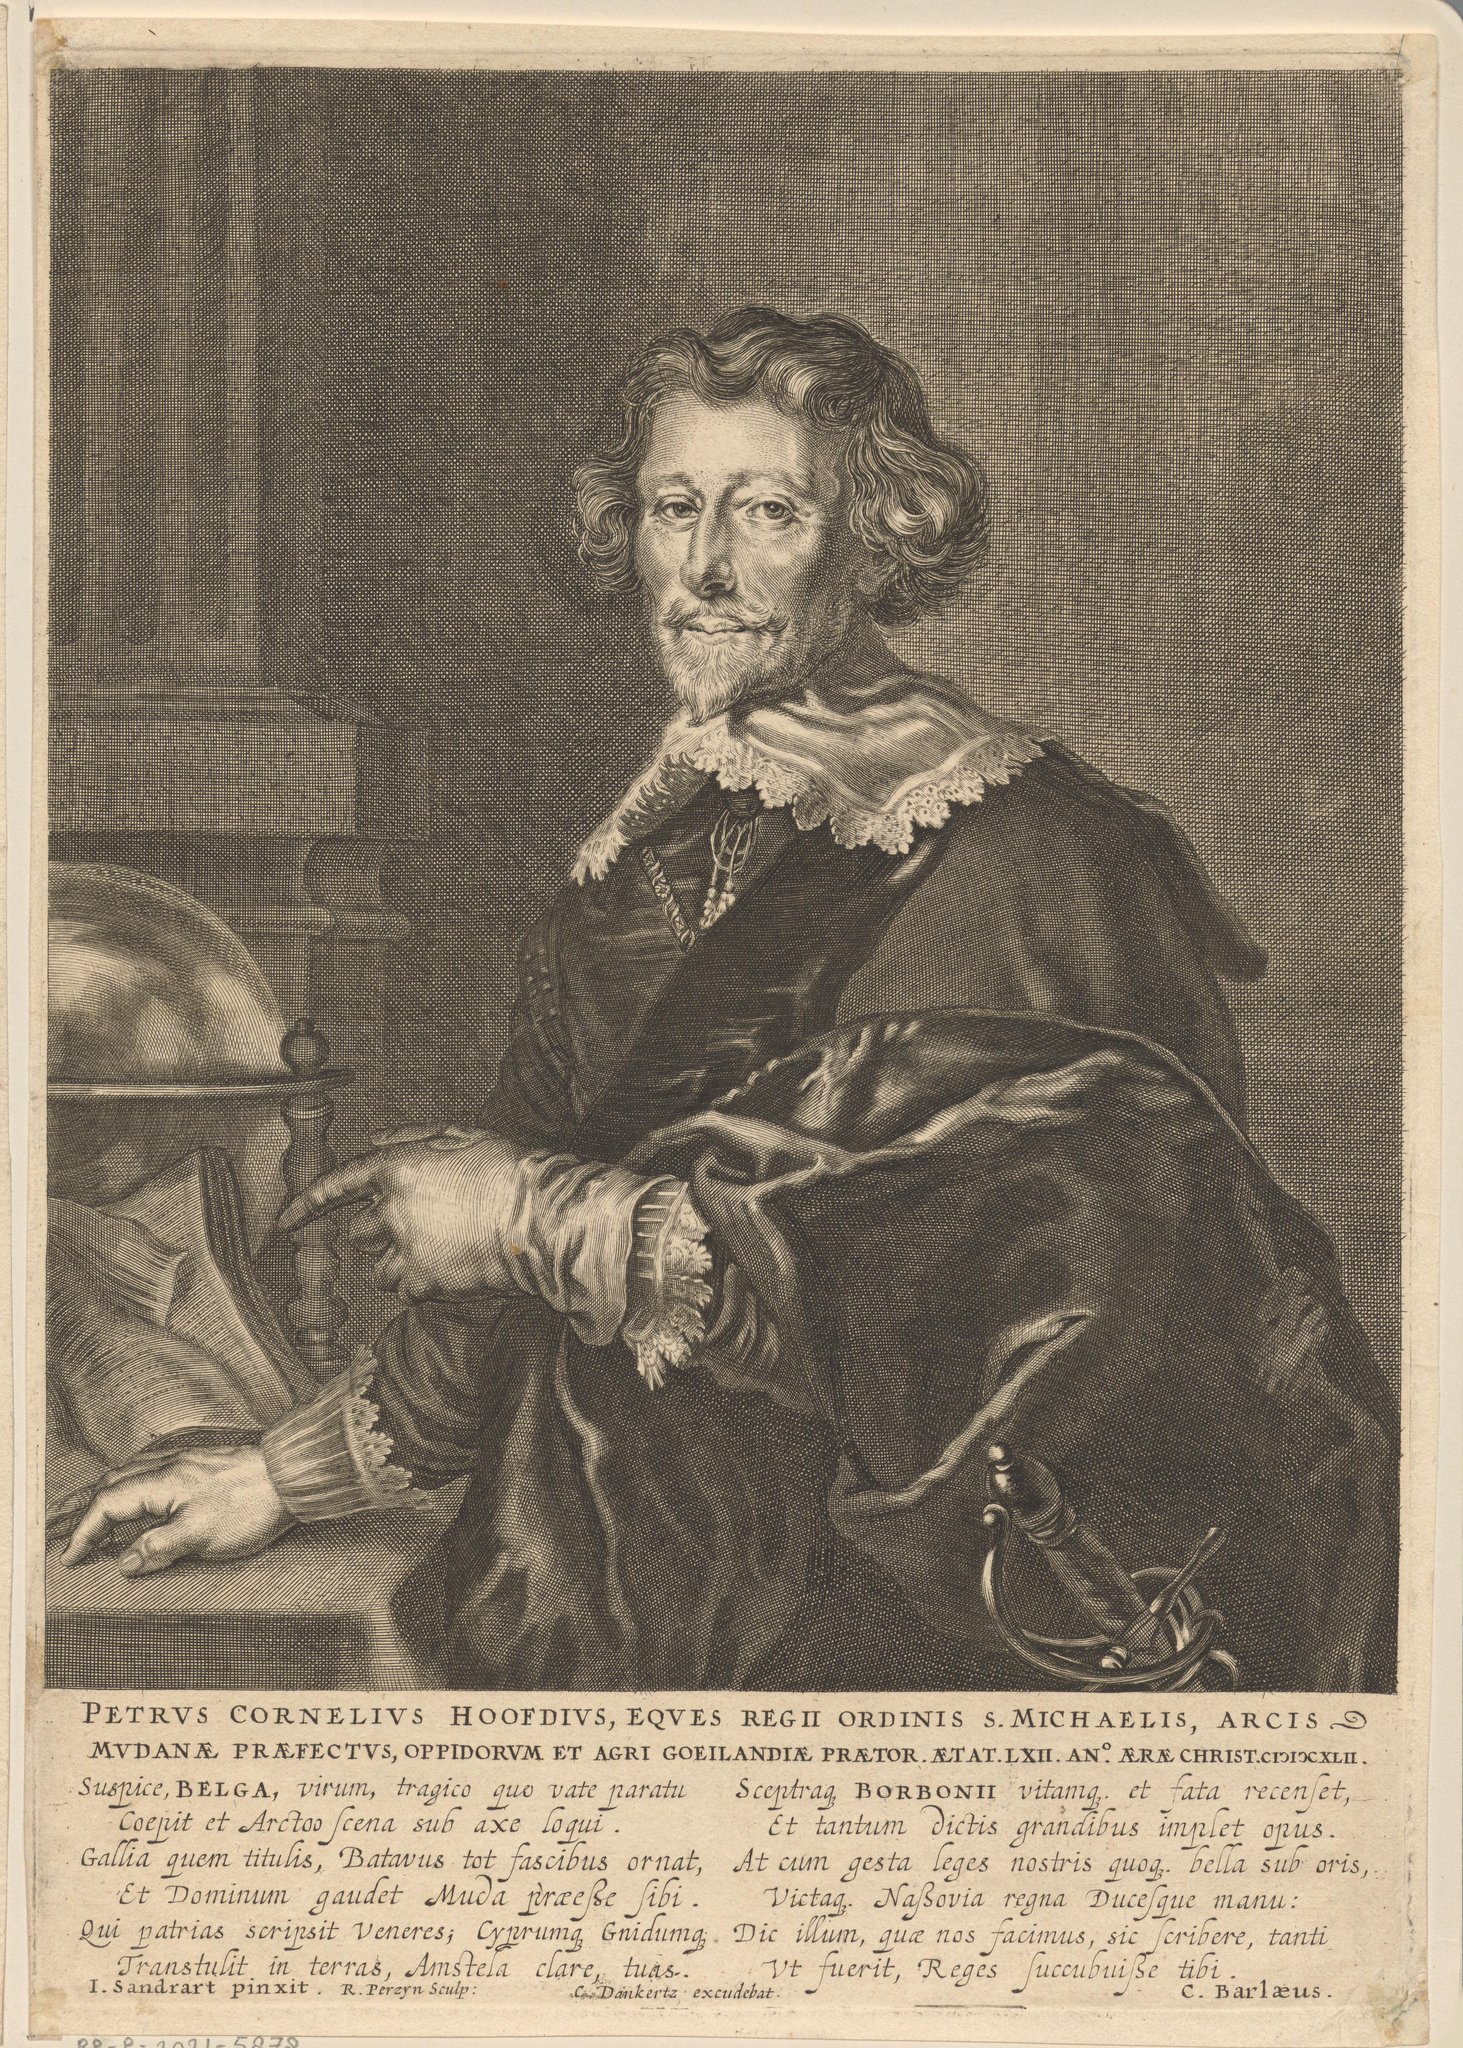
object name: print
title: Portret van Pieter Corneliszoon Hooft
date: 1642-1656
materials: paper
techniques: engraving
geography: amsterdam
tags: amsterdam, the hague, pieter corneliszoon hooft, historical persons, book, writer, poet, author, globe